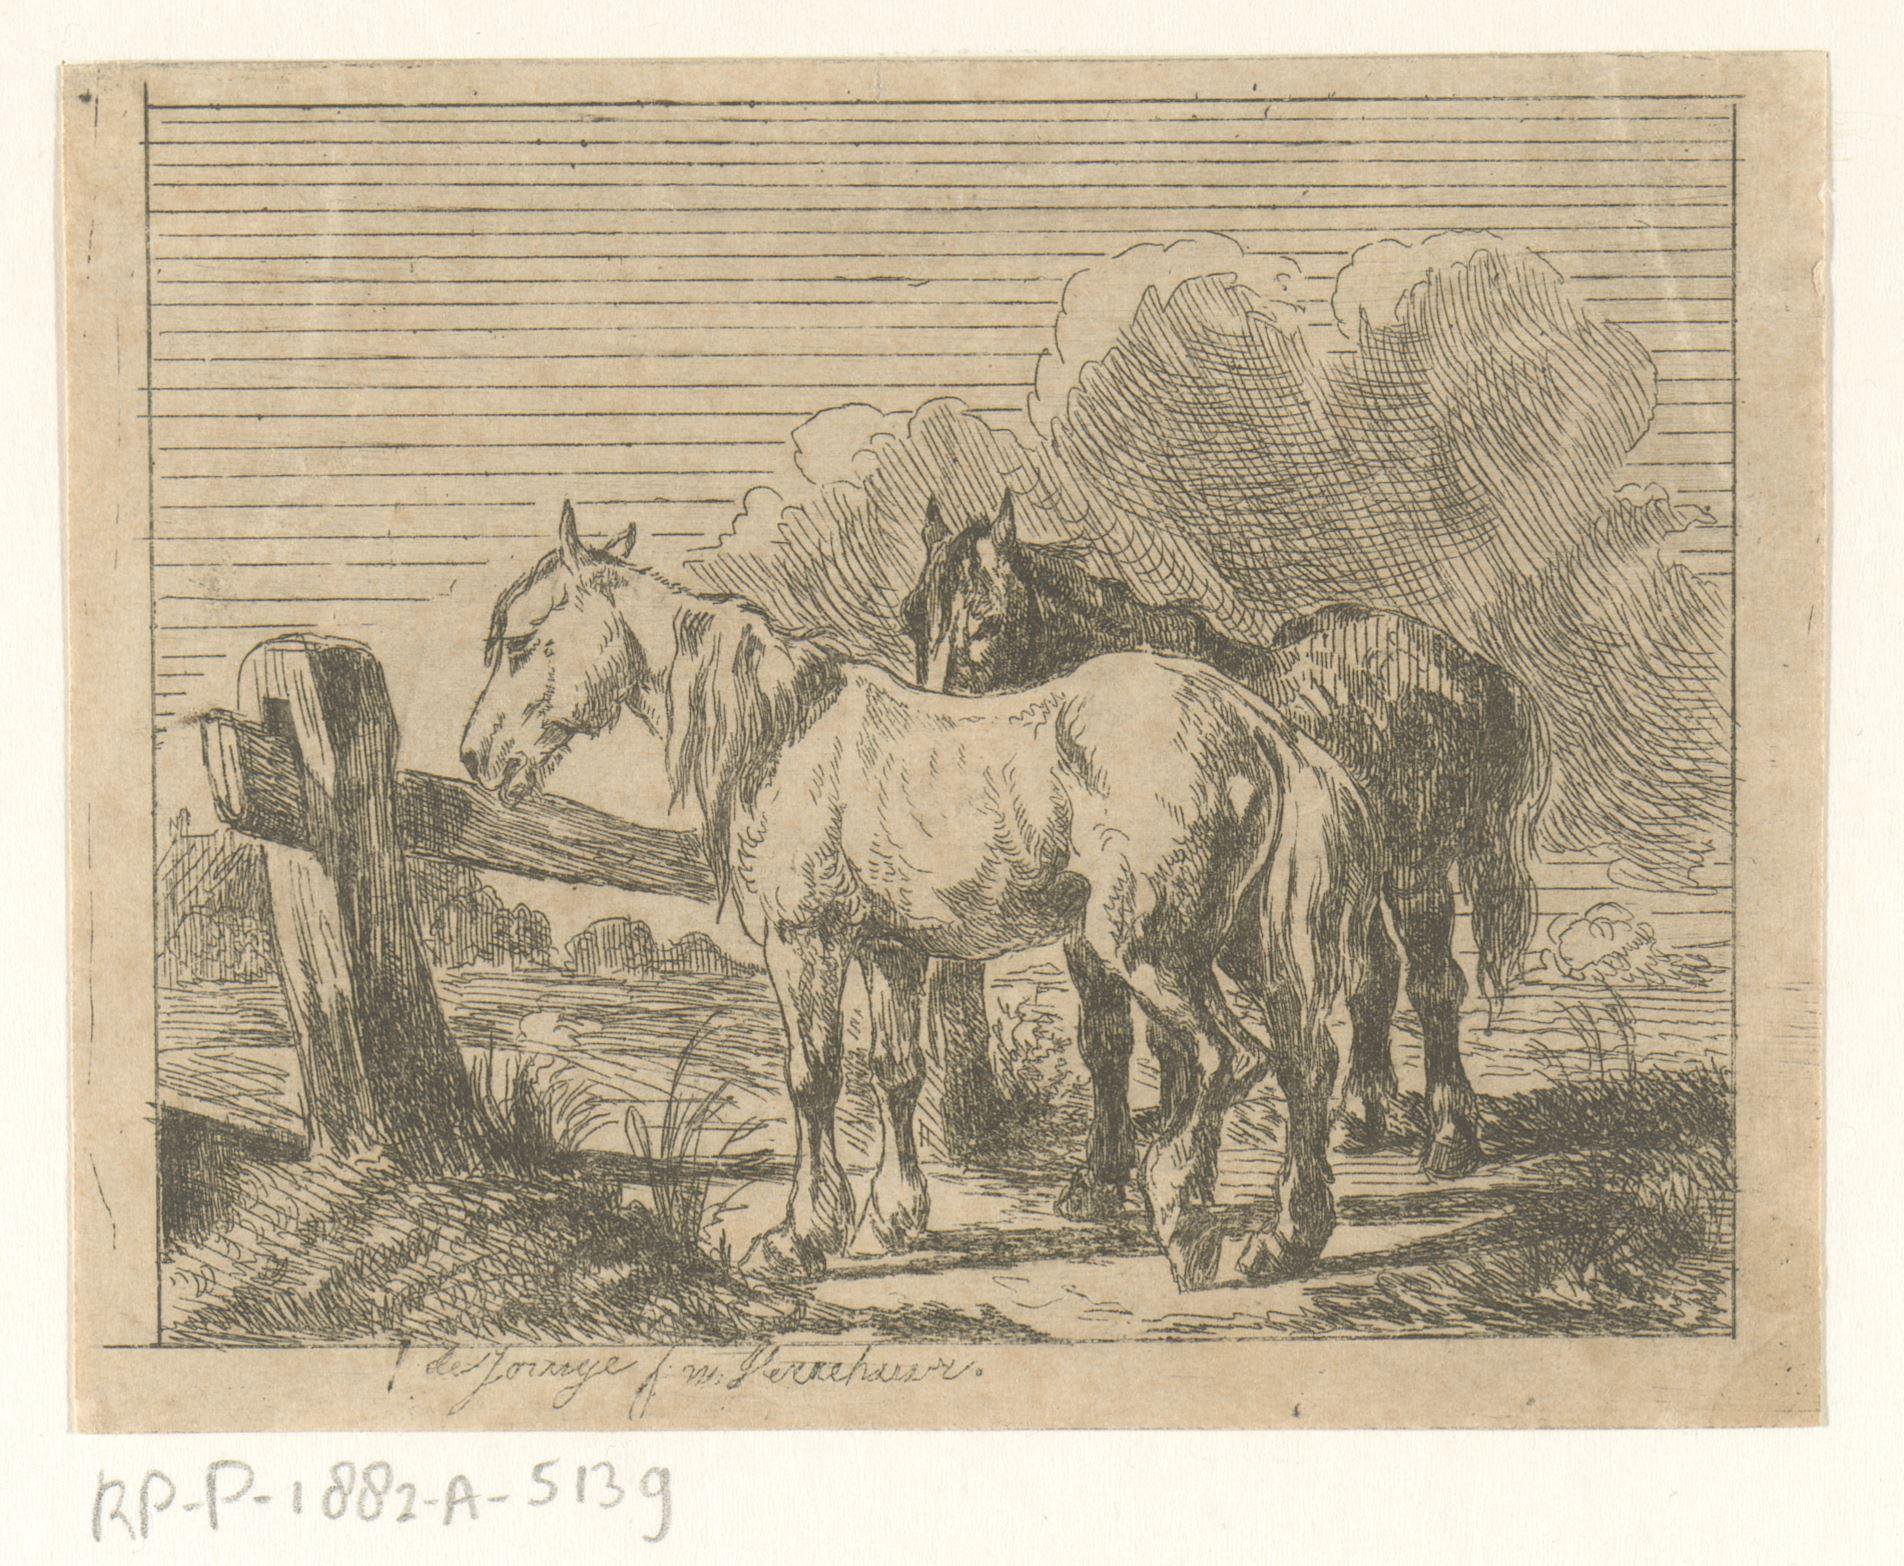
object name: print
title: Weiland met twee paarden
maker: jan karel jacob de jonge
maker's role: draughtsman, print maker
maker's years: 1828-1880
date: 1843-1880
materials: paper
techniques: etching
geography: the hague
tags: horse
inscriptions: collector's mark: Lugt 2228